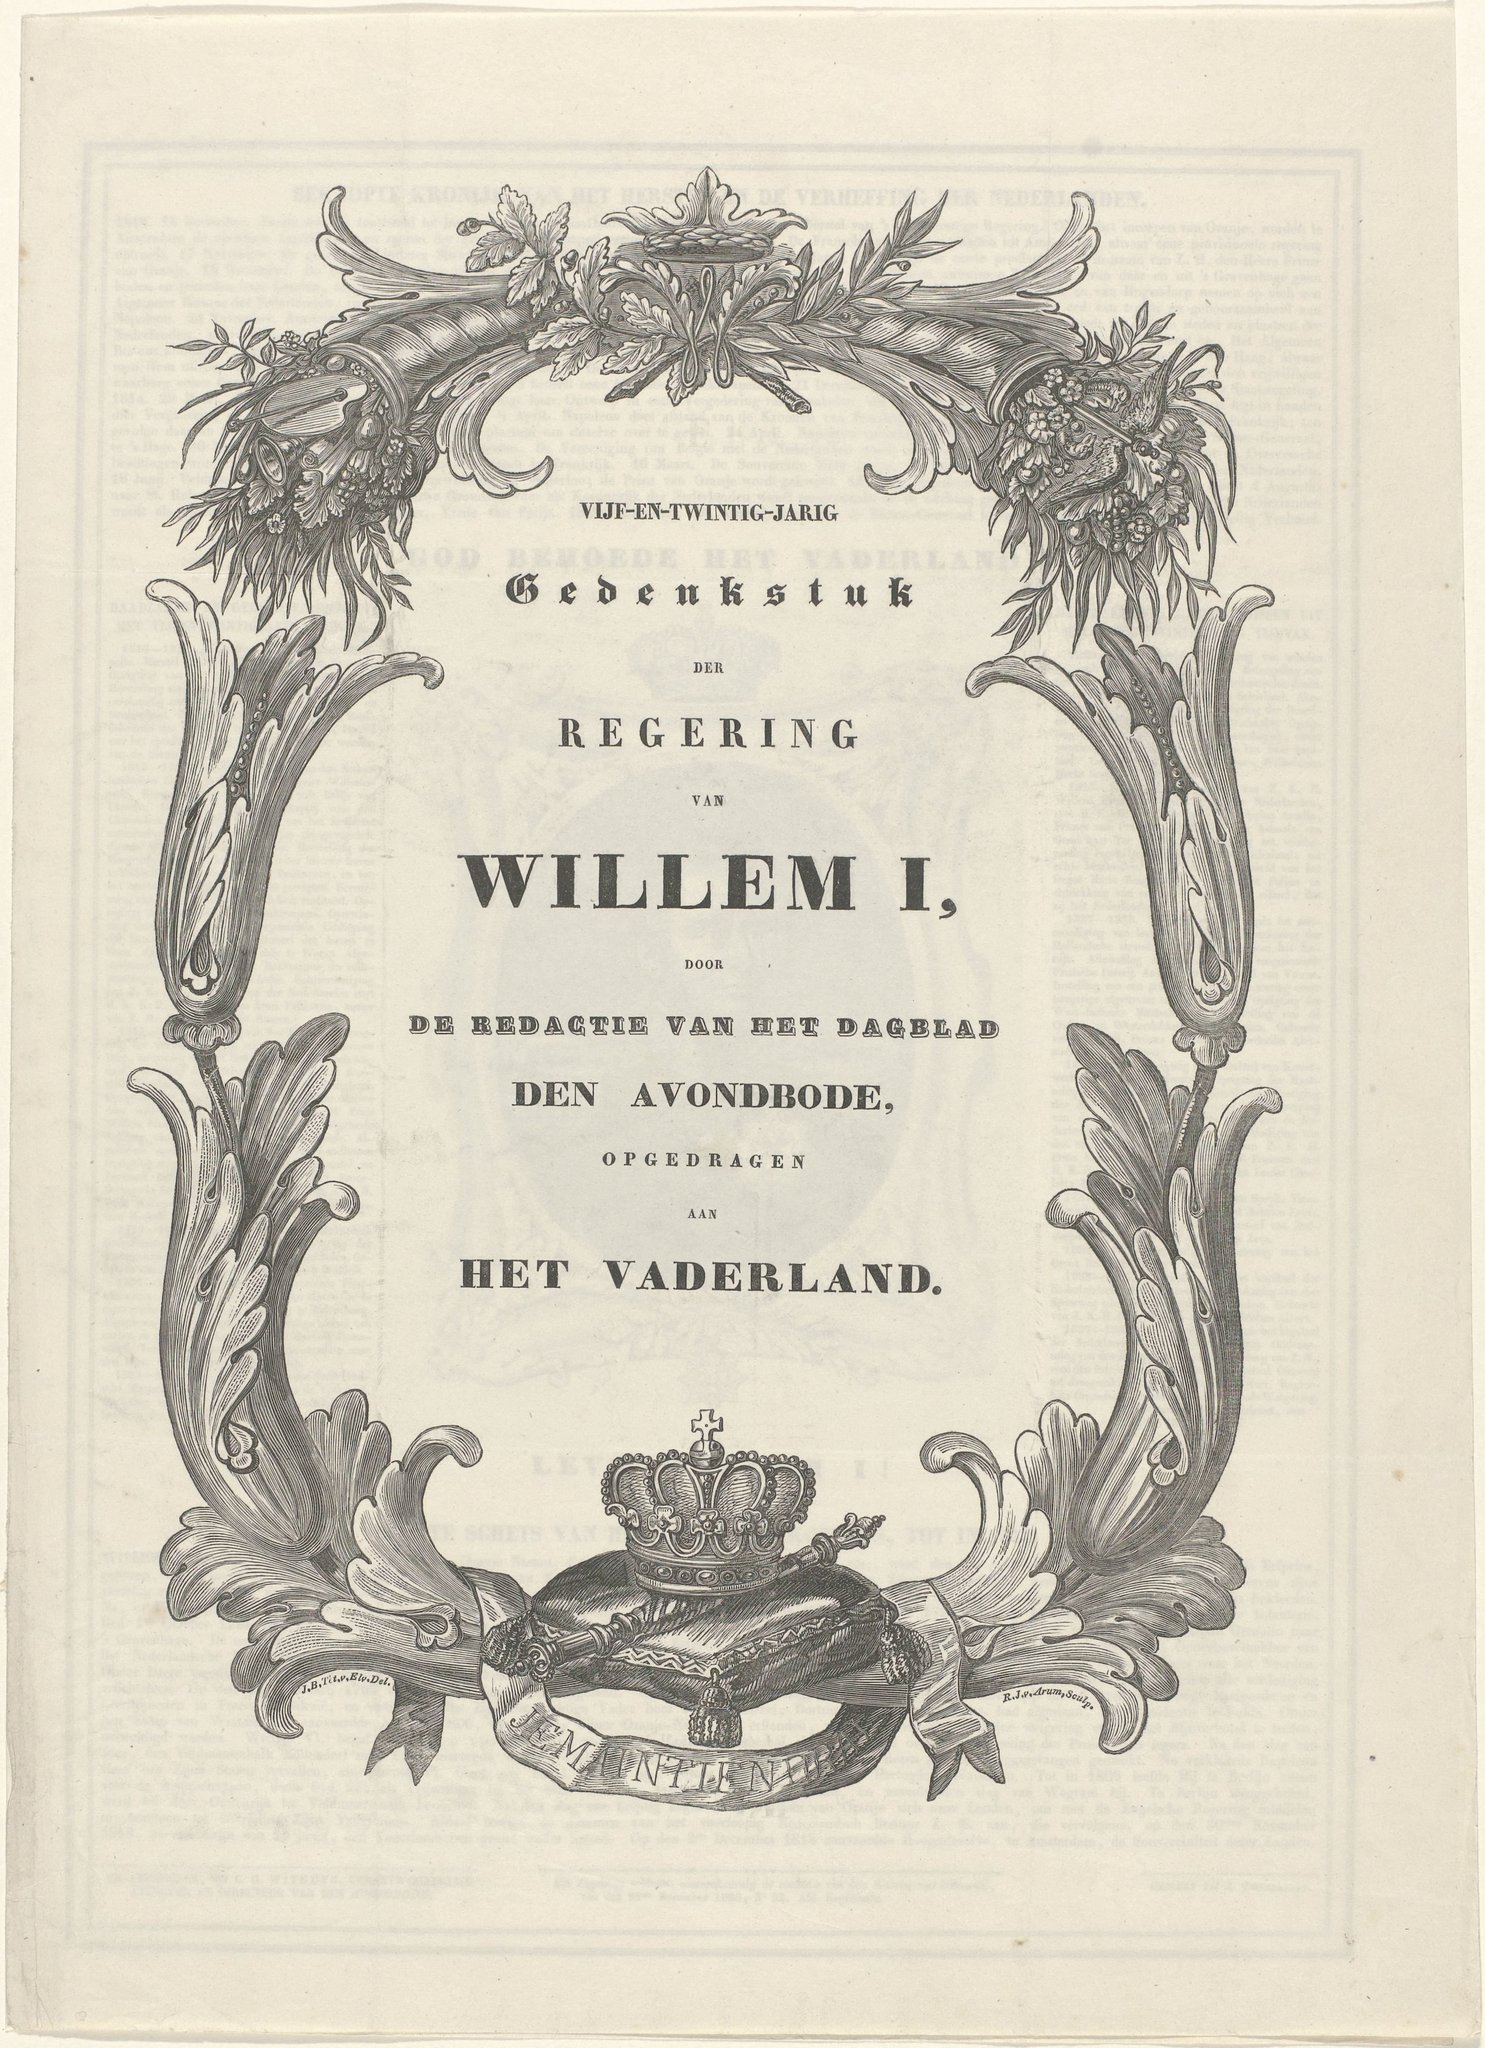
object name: print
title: Vijf-en-twintig-jarig Gedenkstuk der Regering van Willem I, door de redactie van het dagblad Den Avondbode (...) [1838]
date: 1811-1838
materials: paper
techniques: letterpress printing, lithograph, engraving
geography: amsterdam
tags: the hague, berlin, william i of the netherlands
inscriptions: collector's mark: Lugt 2228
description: Speciale uitgave van het dagblad 'Den Avondbode' naar aanleiding van het vijfentwintigjarige regeringsjubileum van koning Willem I, 21 november 1838. Dubbelgevouwen blad met op de voorzijde de titel binnen een ornamentele omlijsting met kroon en scepter. Binnenin één zijde bedrukt met tekst en een portret van de koning.